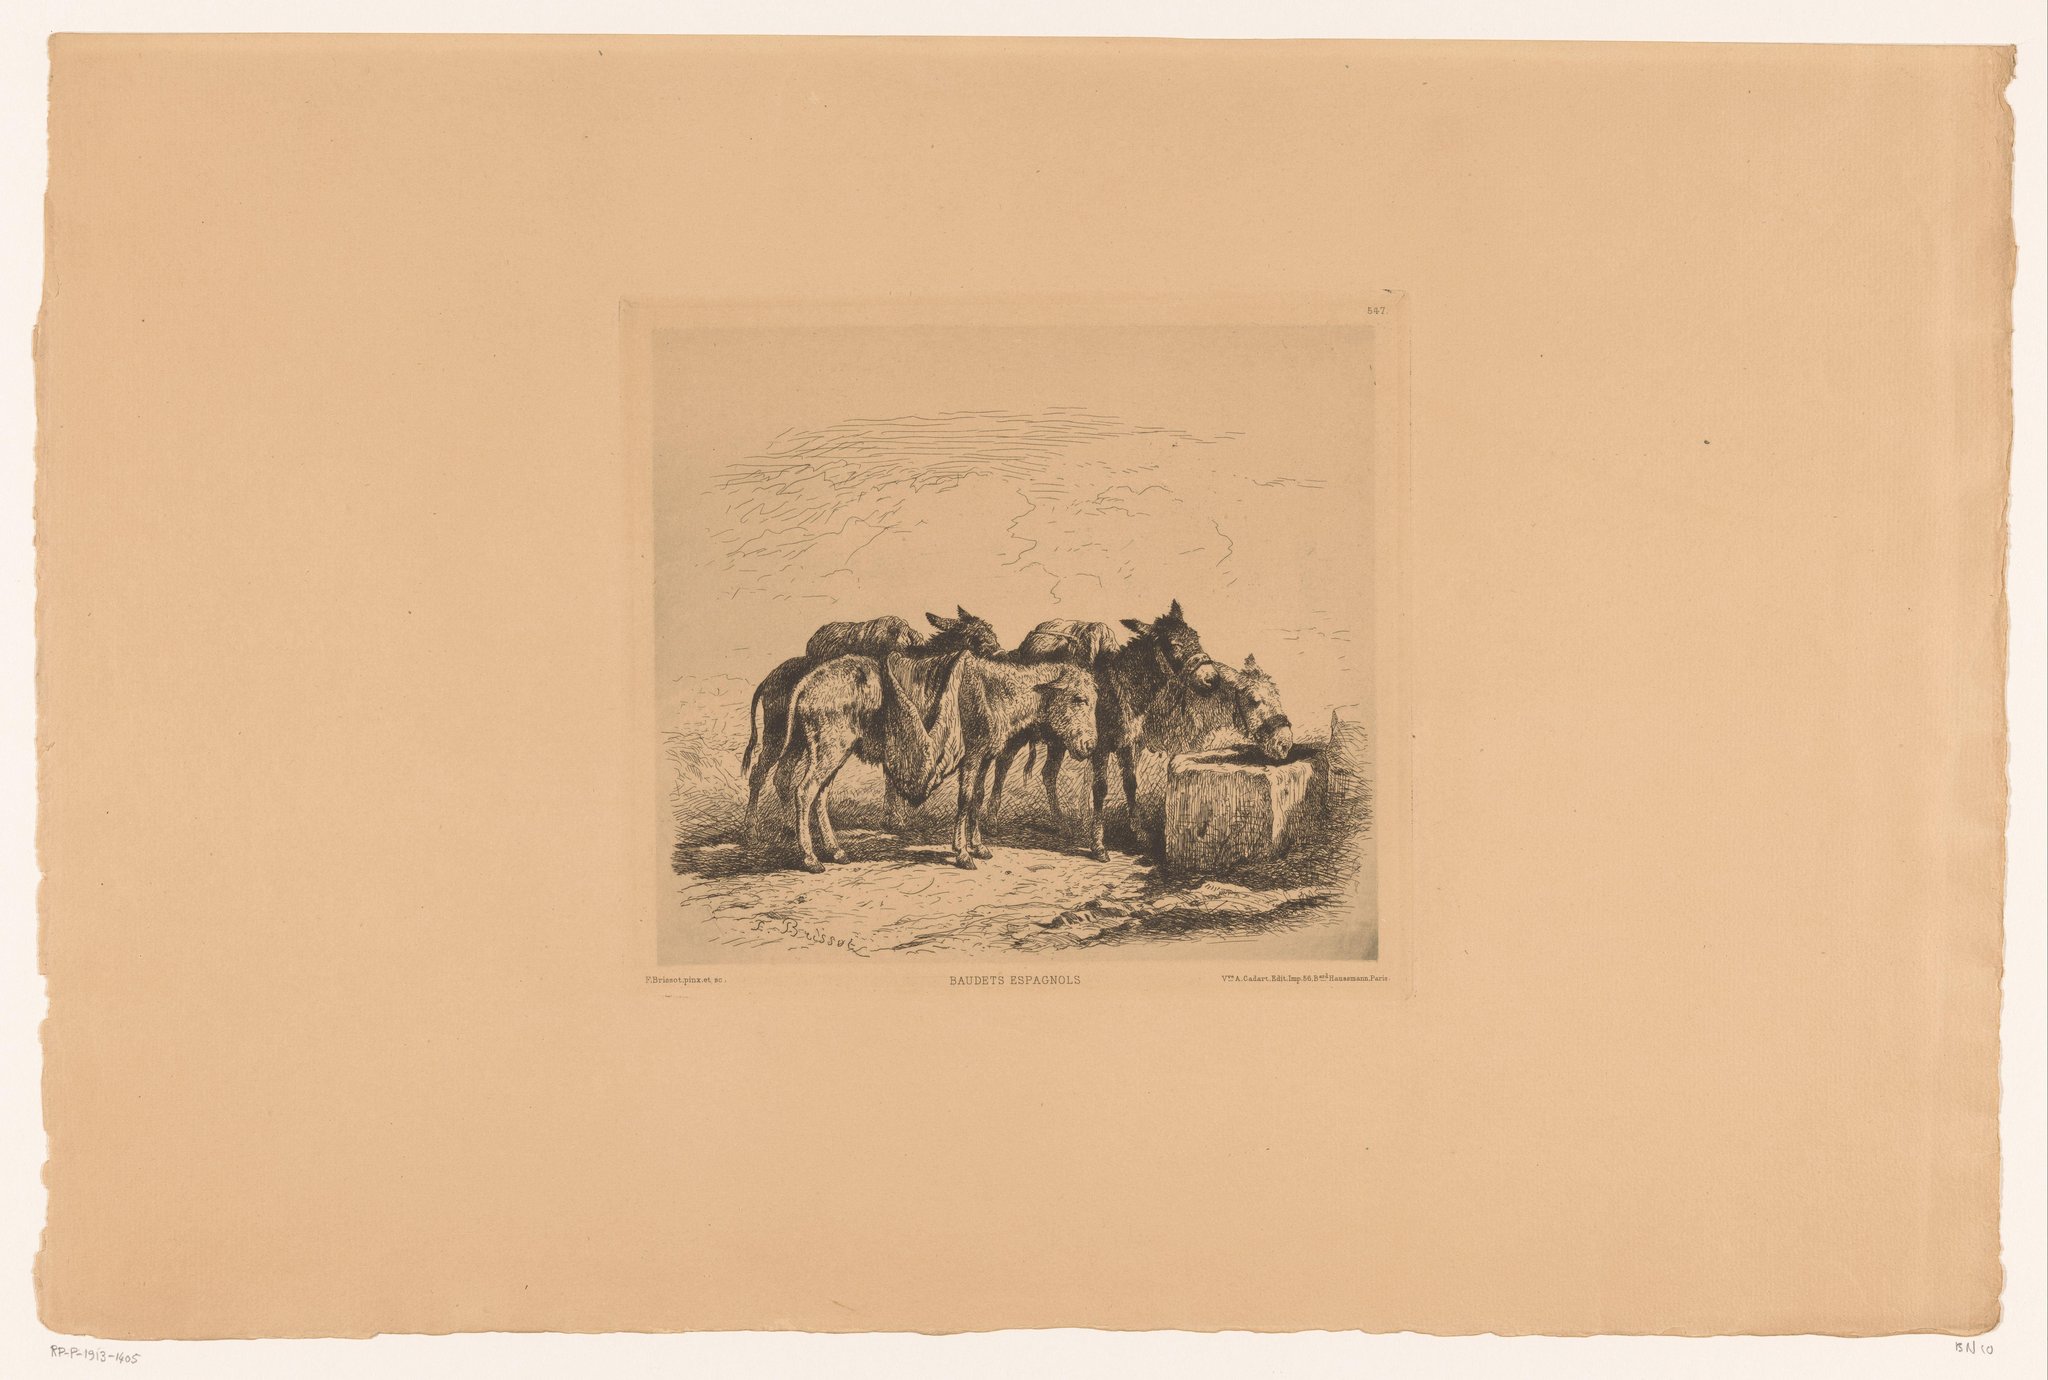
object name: print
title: Baudets Espagnols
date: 1880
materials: paper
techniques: etching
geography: paris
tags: trough, ass, donkey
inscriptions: collector's mark: Lugt 2233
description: Gepubliceerd in 'L'illustration Nouvelle de Cadart' als nr. 547 in 1880.